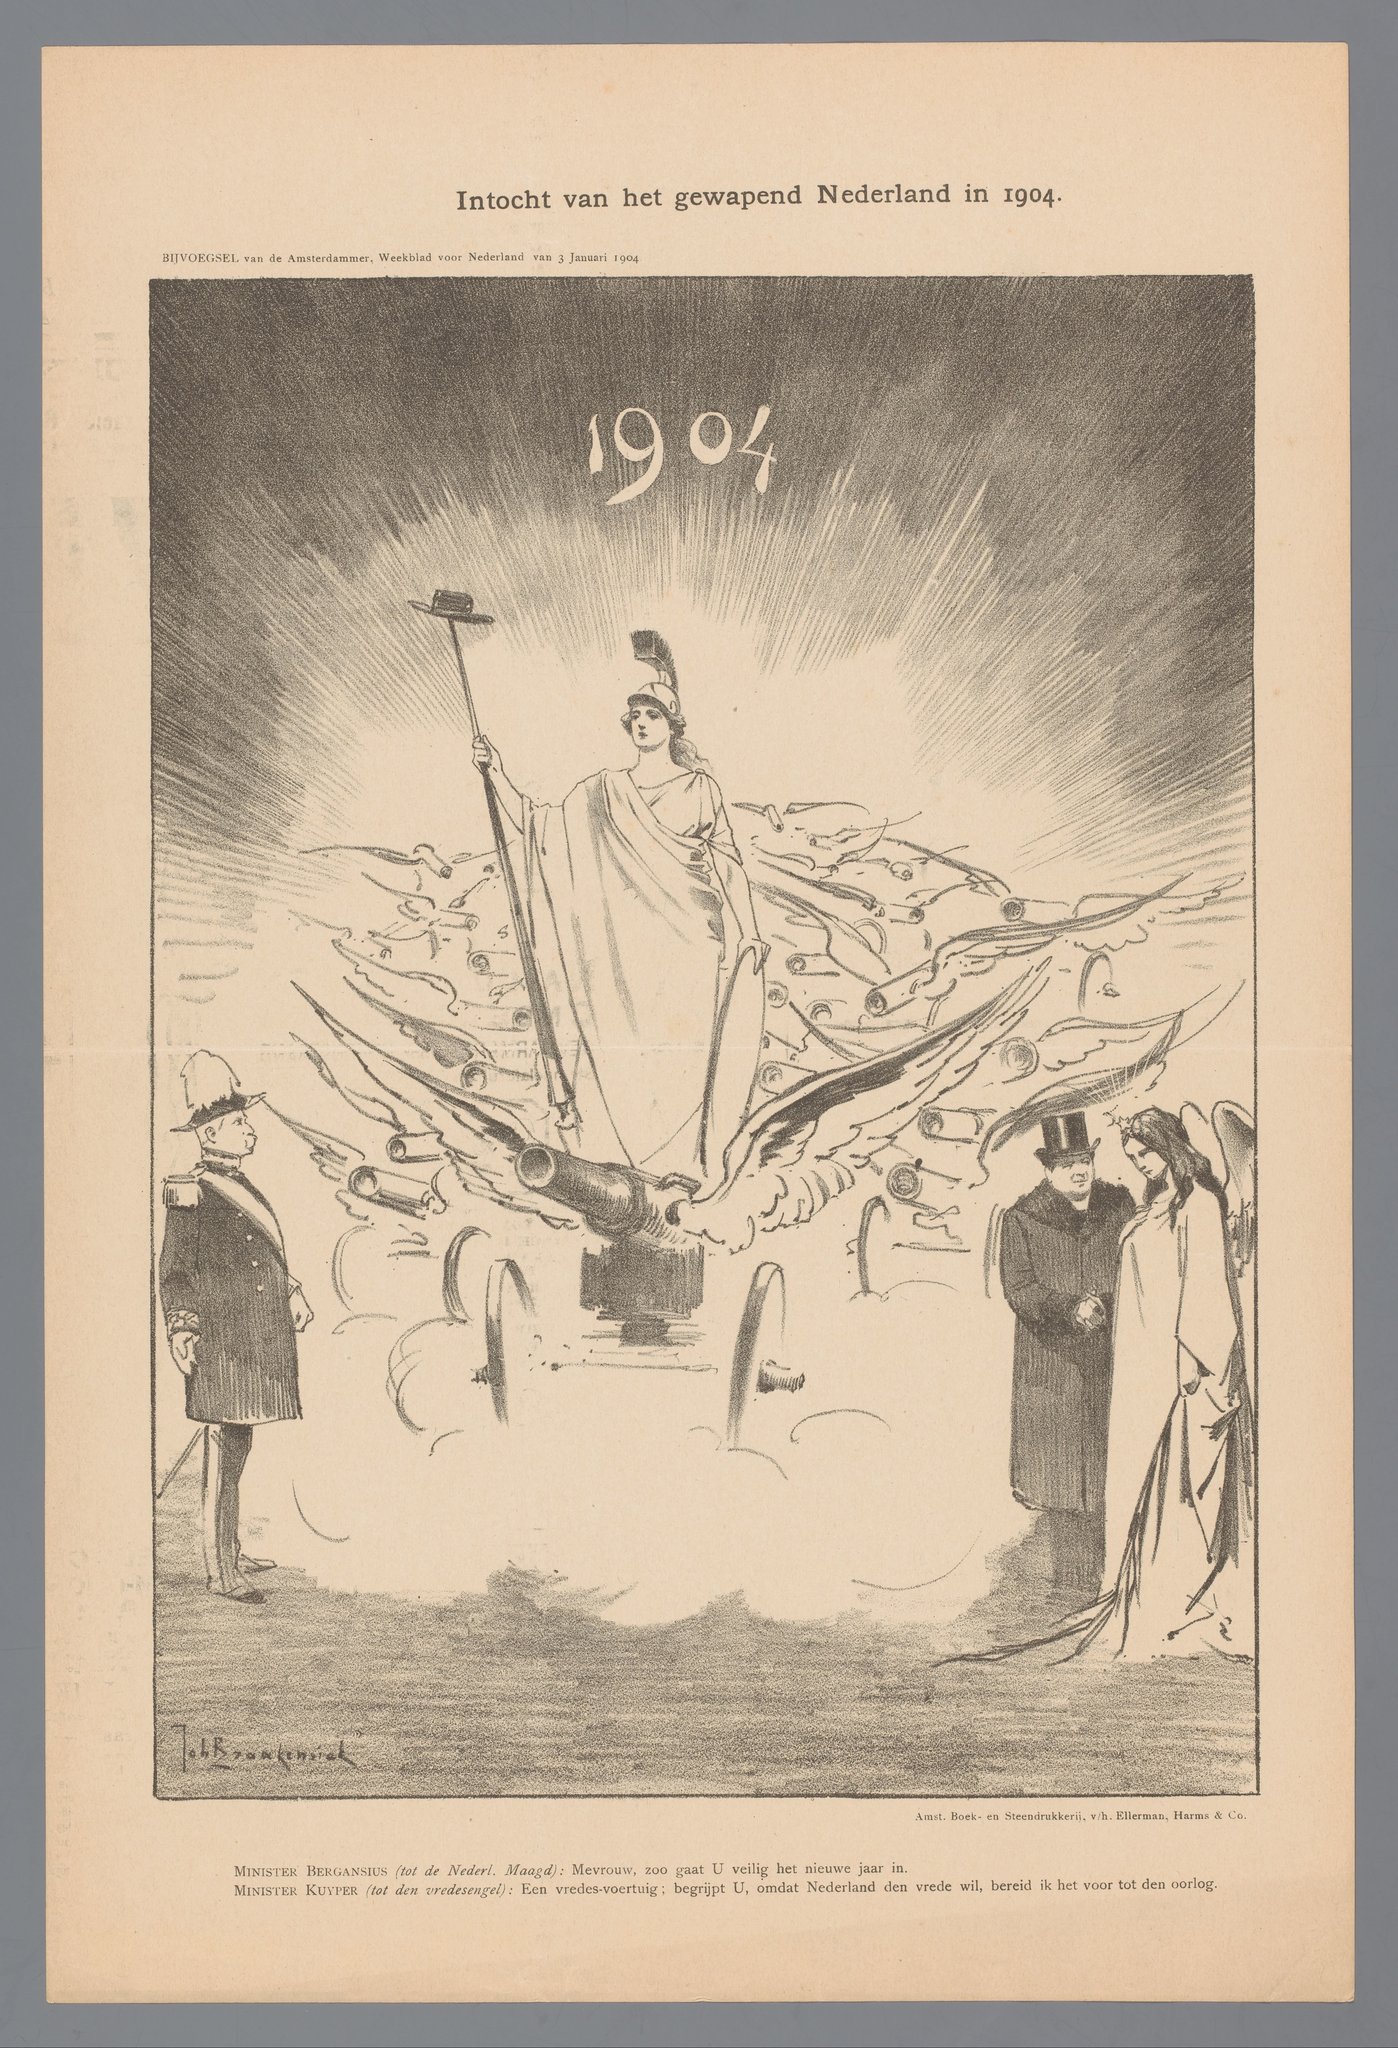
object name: cartoon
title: Intocht van het gewapend Nederland in 1904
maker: johan braakensiek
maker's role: draughtsman, print maker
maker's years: 1858-1940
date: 1904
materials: paper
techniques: lithograph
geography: amsterdam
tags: the hague, abraham kuyper, symbols, allegories of peace, 'pax'; 'pace' (ripa), historical persons, political caricatures and satires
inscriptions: date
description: Prent uit het bijvoegsel van: De Amsterdammer. Weekblad voor Nederland, 3 januari 1904.